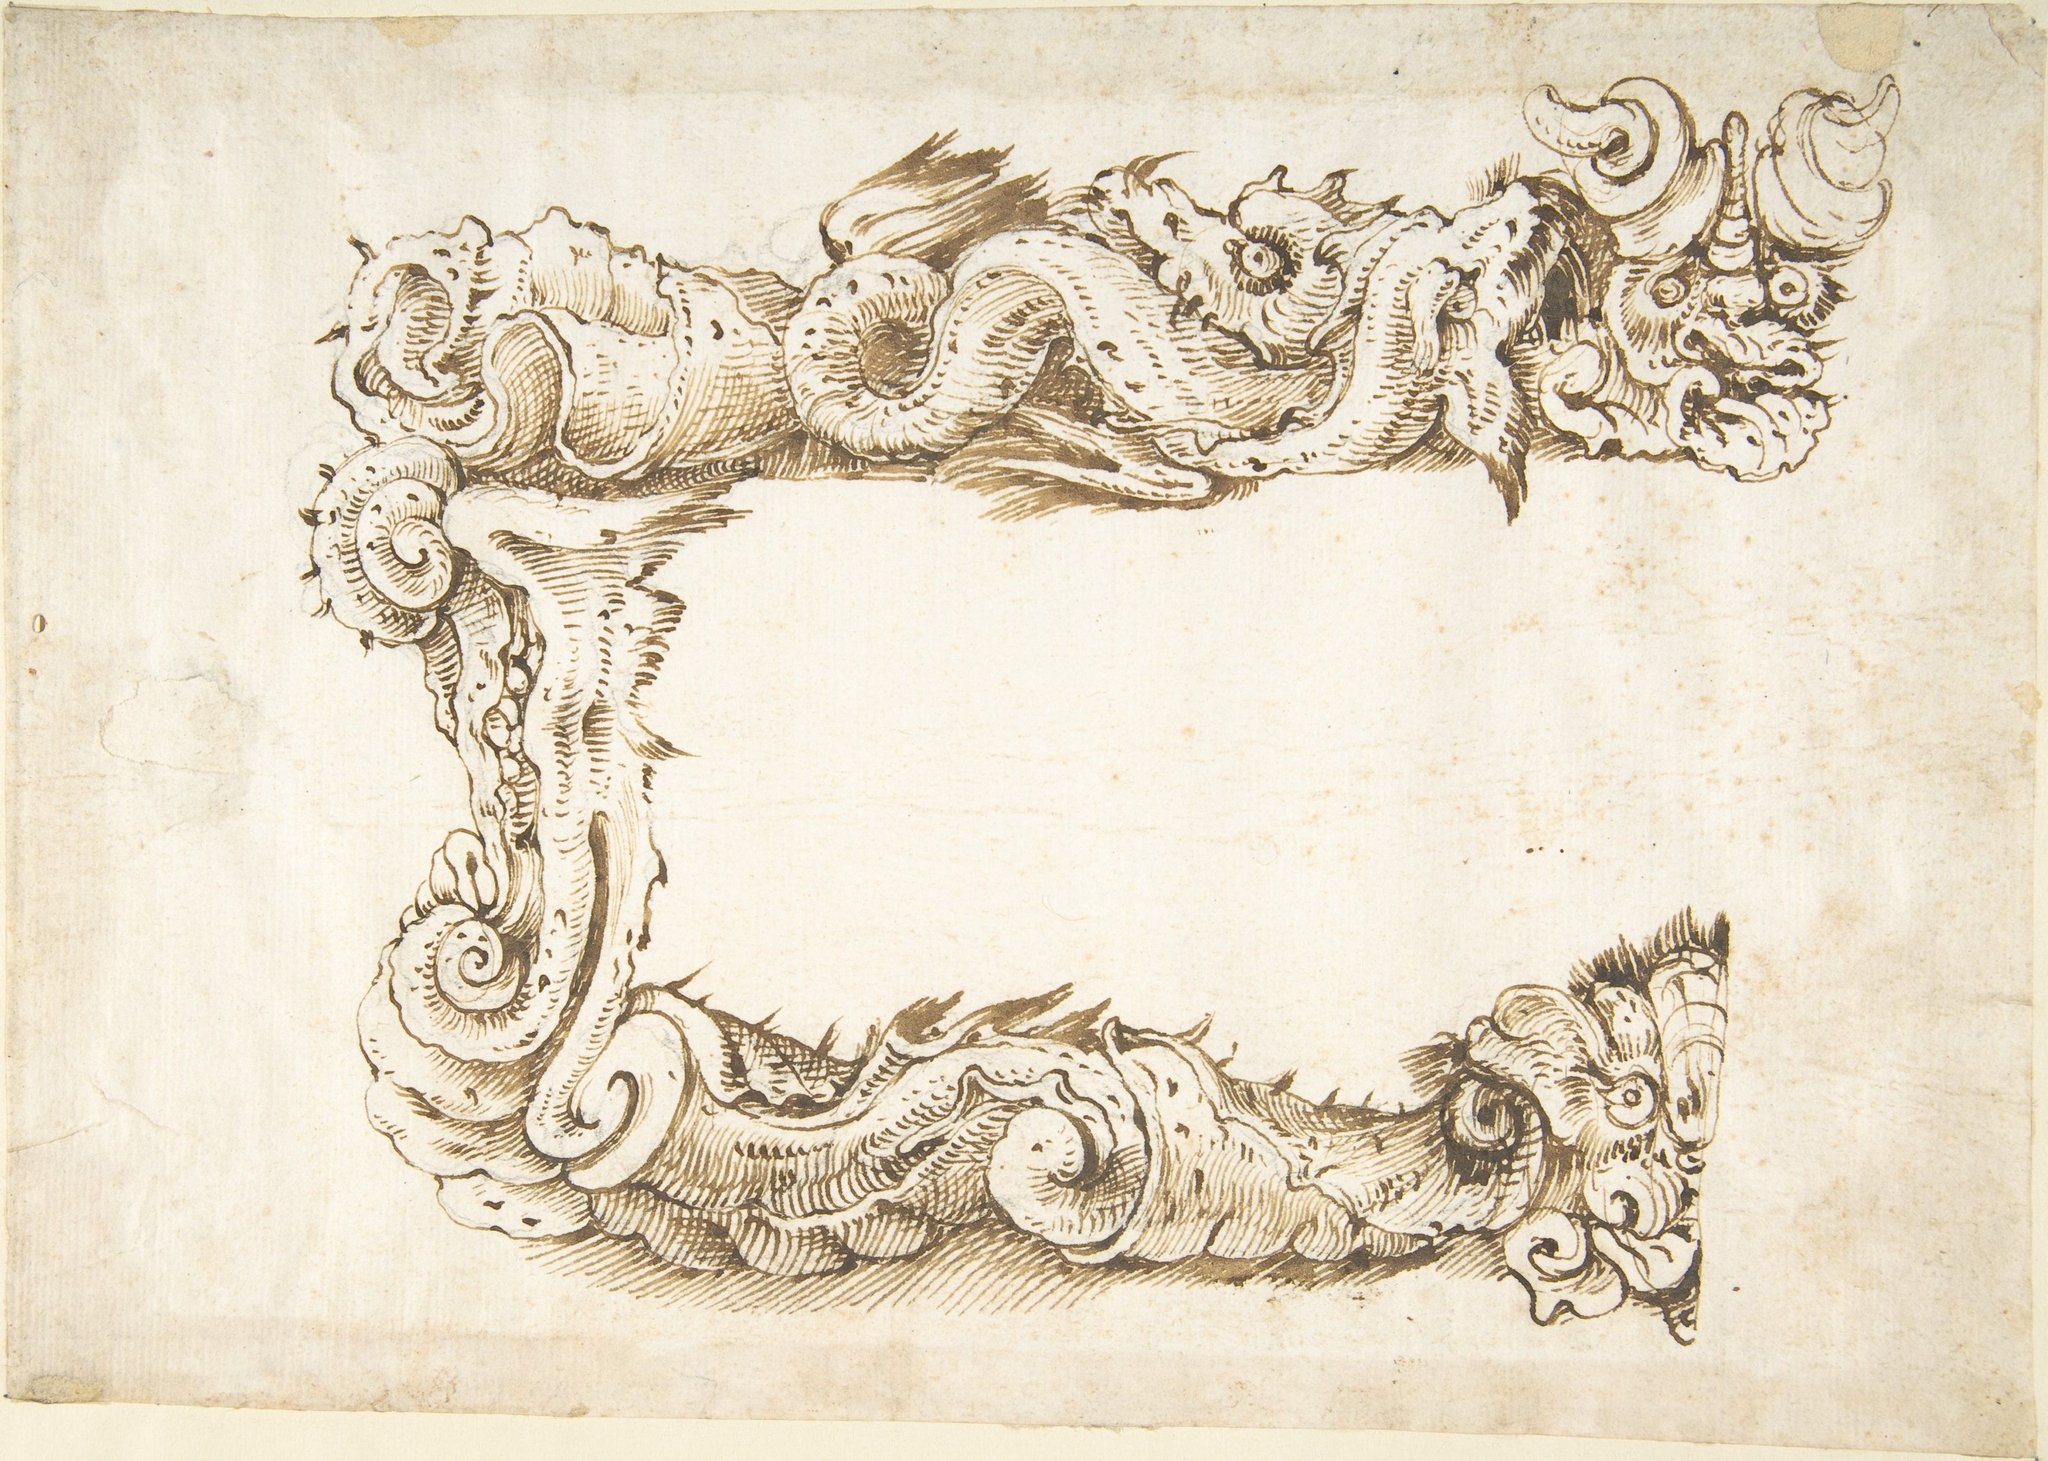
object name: drawing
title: Half of a Cartouche with Monsters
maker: quentin pierre chedel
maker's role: artist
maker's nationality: french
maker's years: 1705-1763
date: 1701-1800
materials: chalk, ink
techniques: brush, pen, drawing, wash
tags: cartouches,monsters